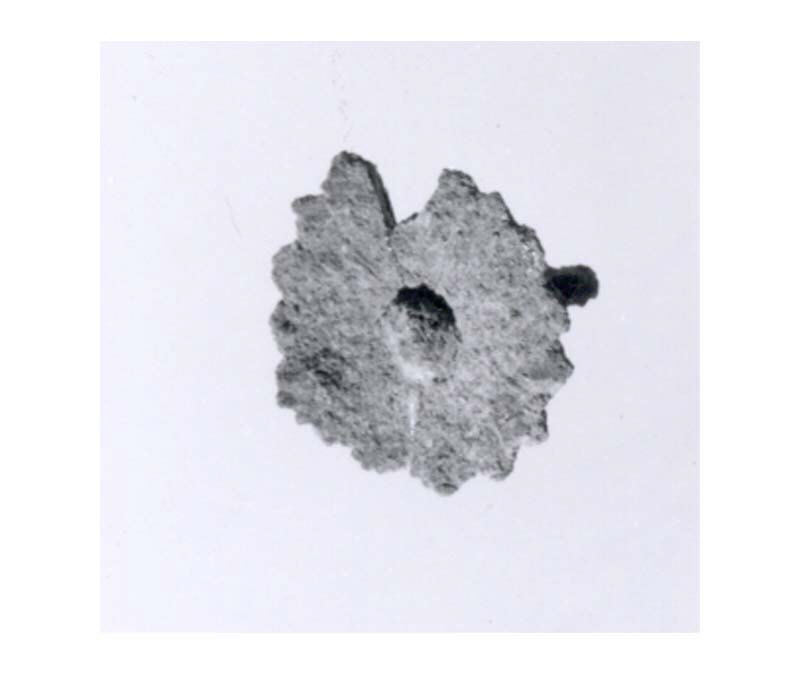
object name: rosette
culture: assyrian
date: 900-601 BCE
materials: copper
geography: mesopotamia